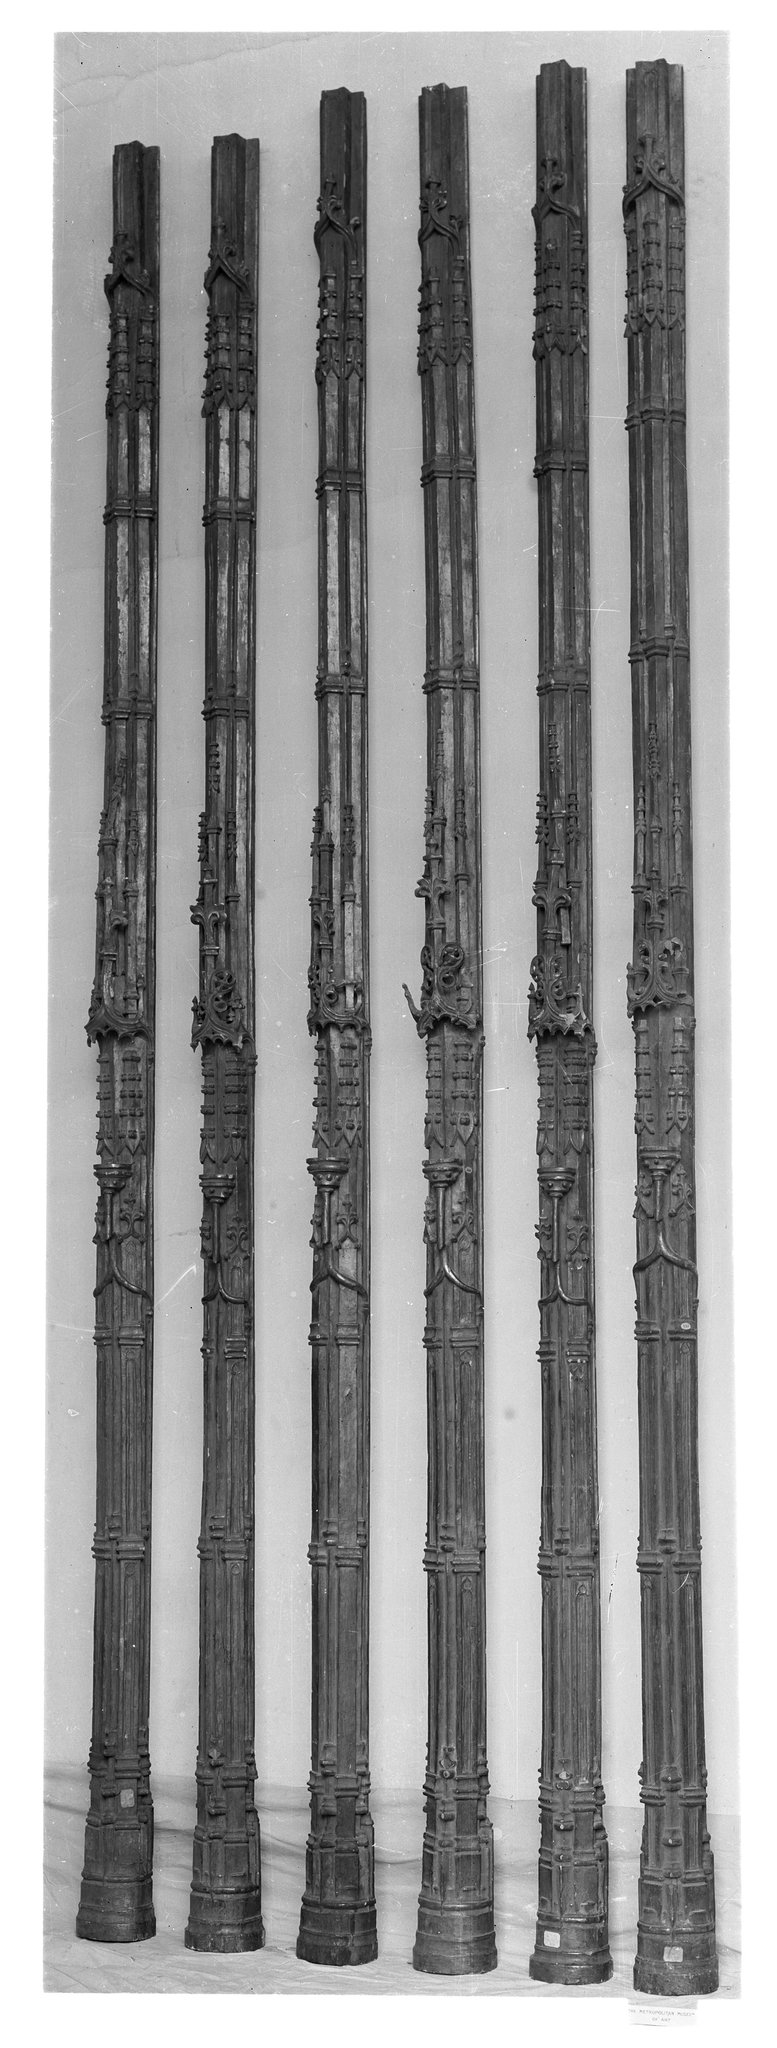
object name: pilaster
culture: french or italian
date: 1501-1600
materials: gold leaf, wood